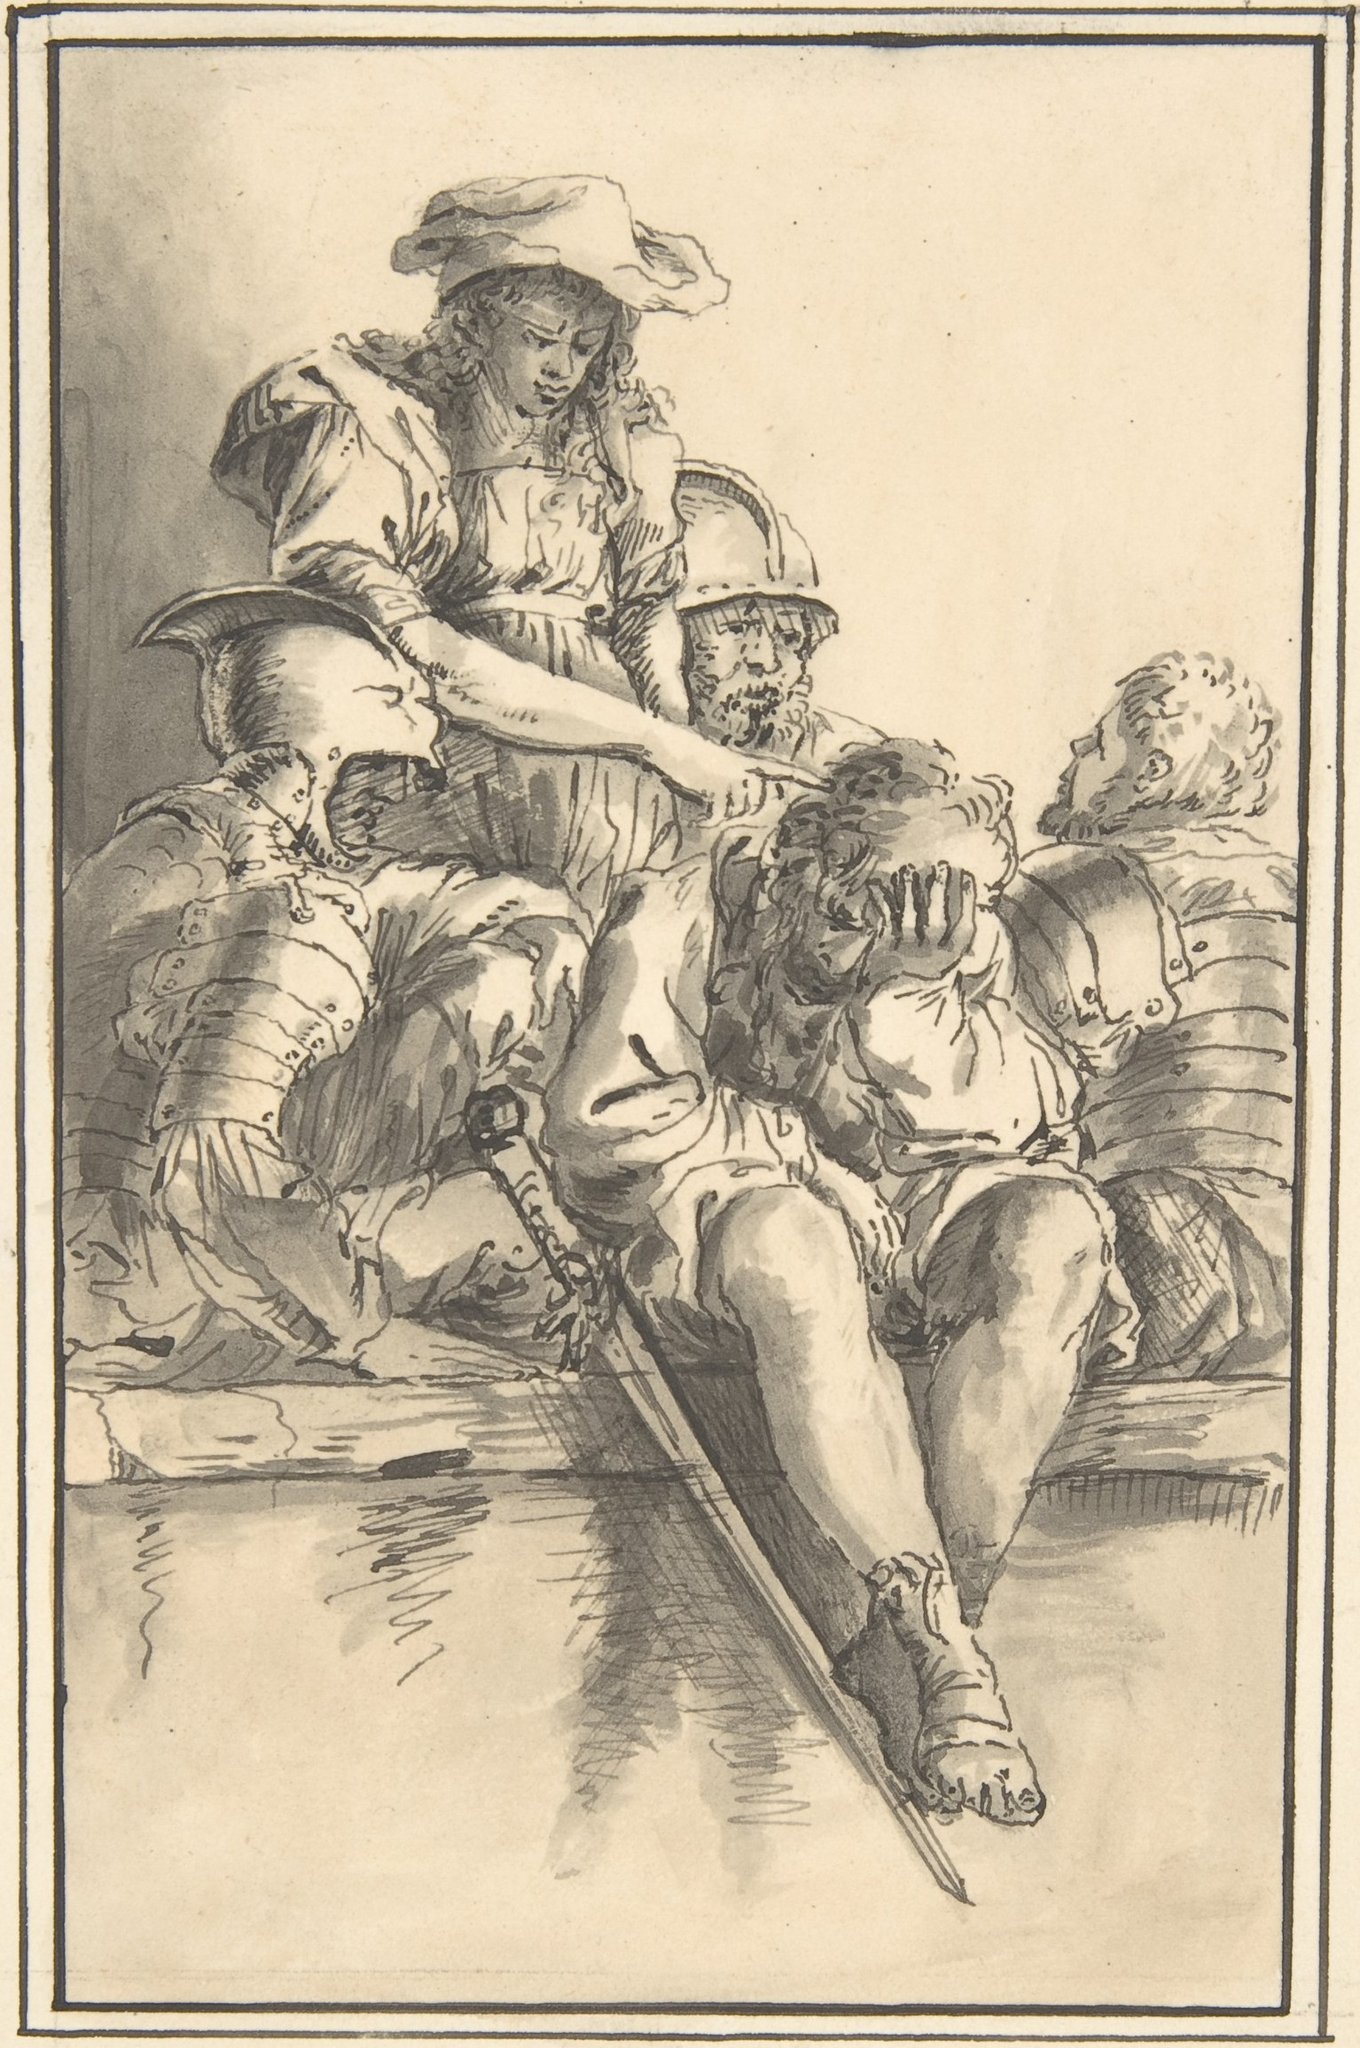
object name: drawing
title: Scene with Banditti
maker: anonymous, british, late 18th–early 19th century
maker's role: artist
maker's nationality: british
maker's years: 1771-1835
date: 1734-1833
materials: ink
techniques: brush, pen, wash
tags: soldiers,swords,men,women